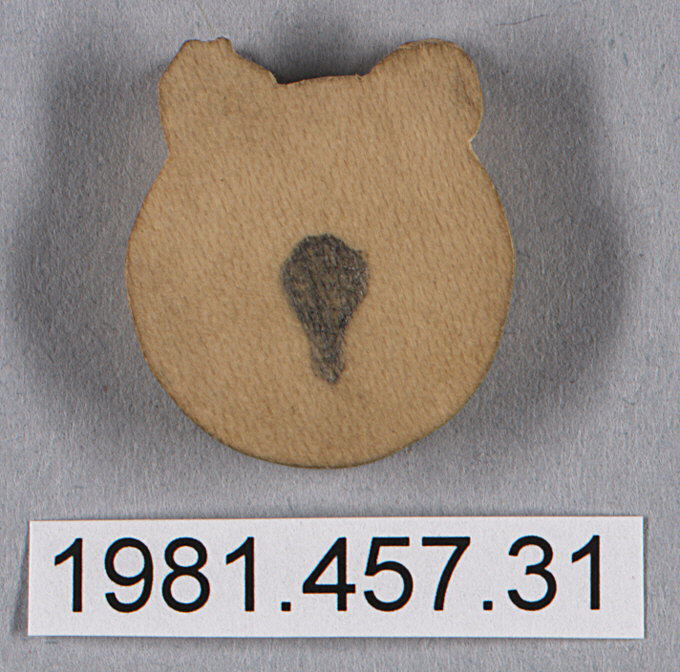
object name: sewing accessory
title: Wood piece (sewing accessory)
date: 1801-1900